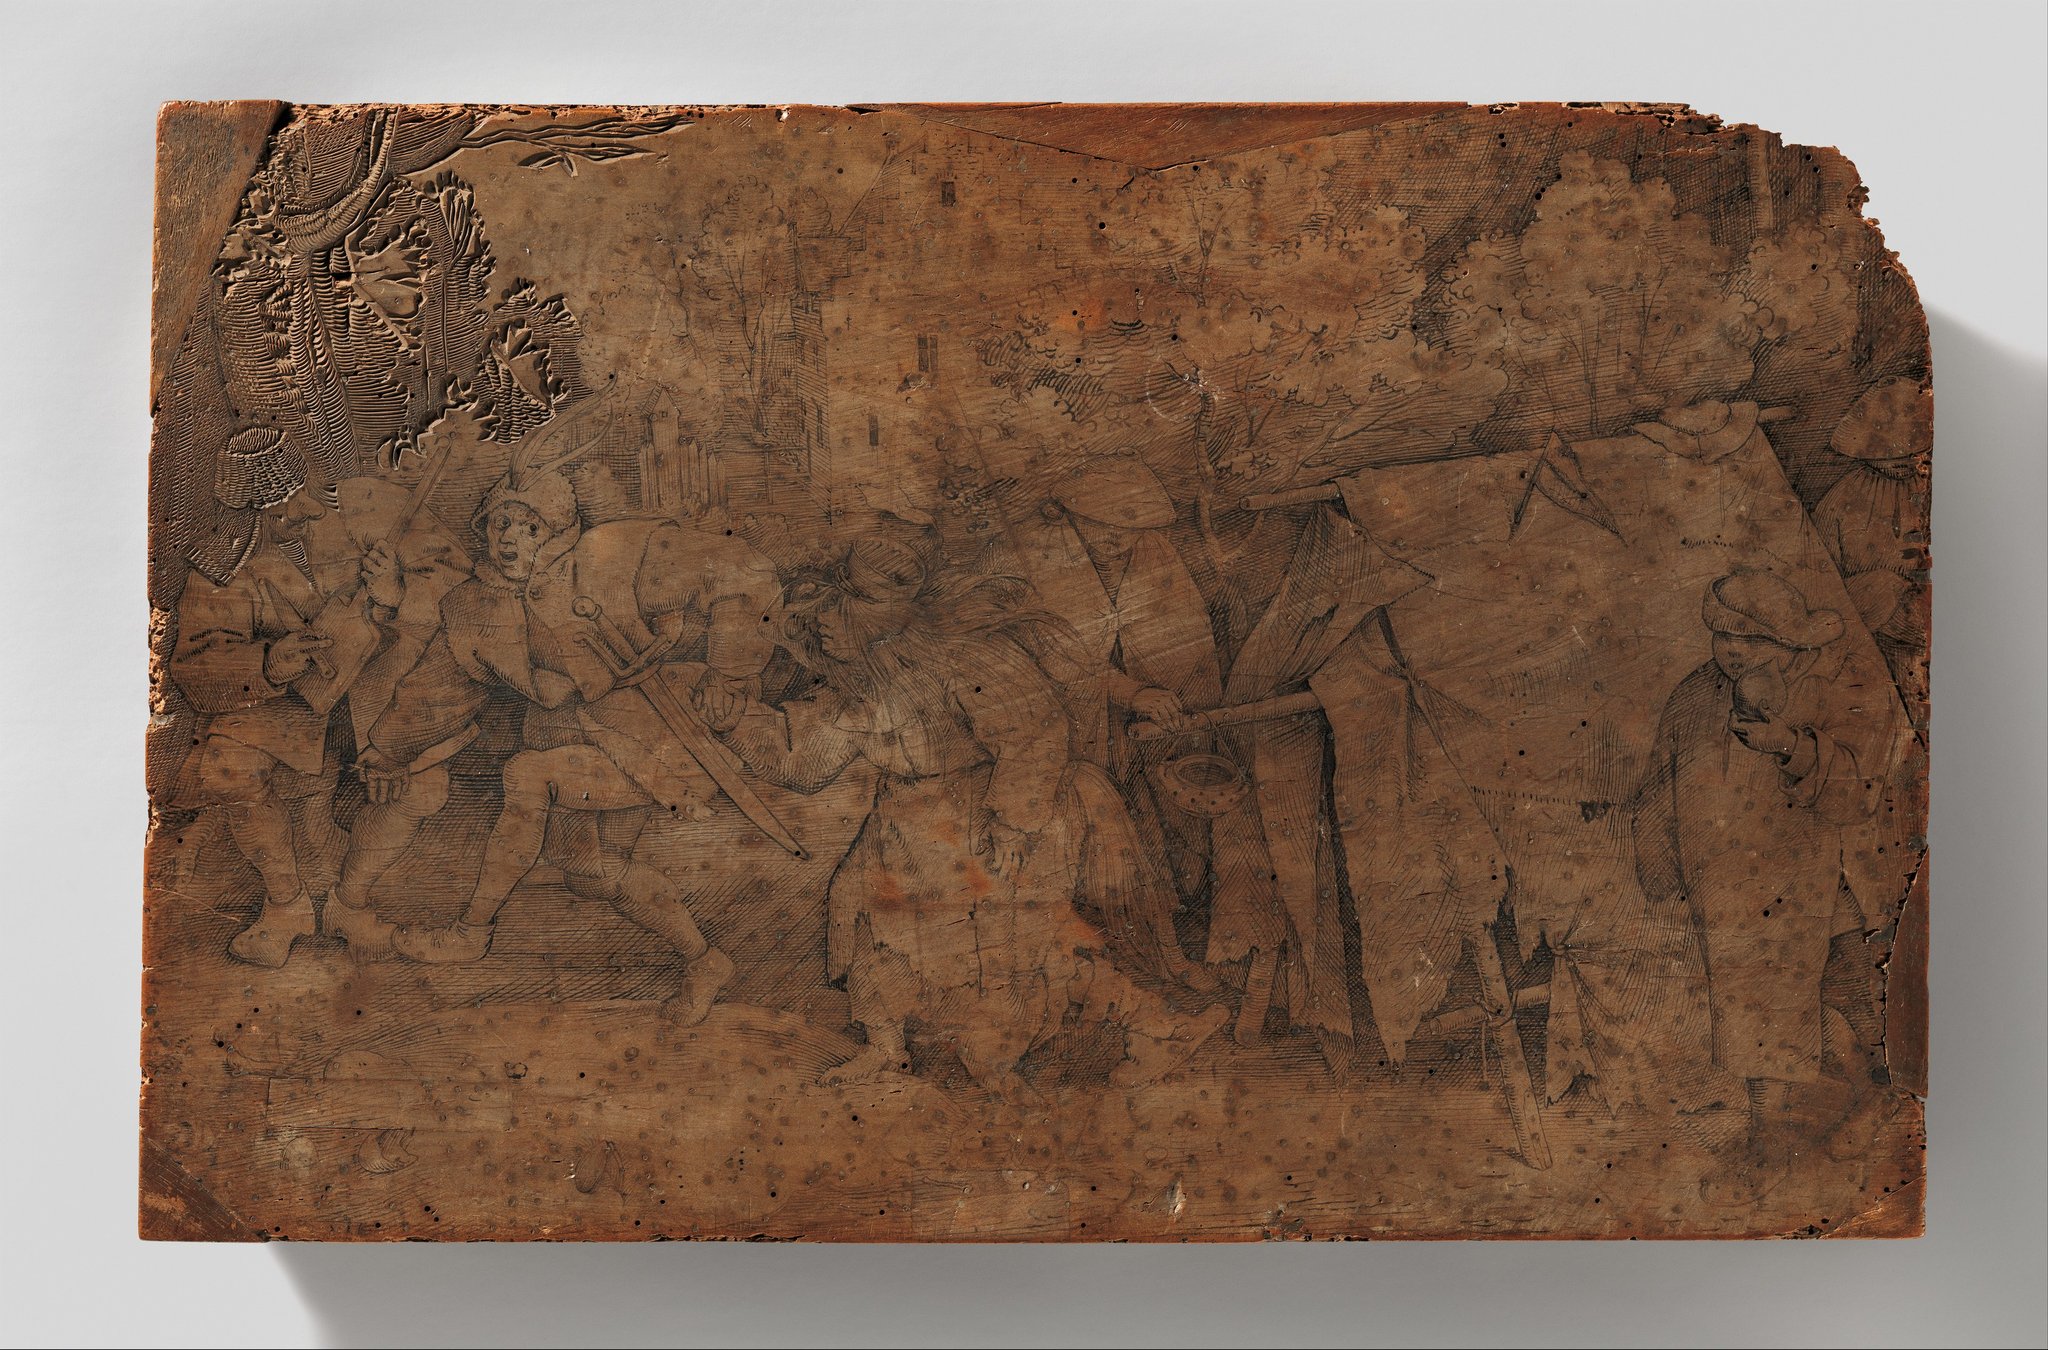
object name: block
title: The Dirty Bride or The Wedding of Mopsus and Nisa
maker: pieter bruegel the elder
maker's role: artist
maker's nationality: netherlandish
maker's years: 1525-1569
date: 1566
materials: ink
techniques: carving, pen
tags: tents,men,women